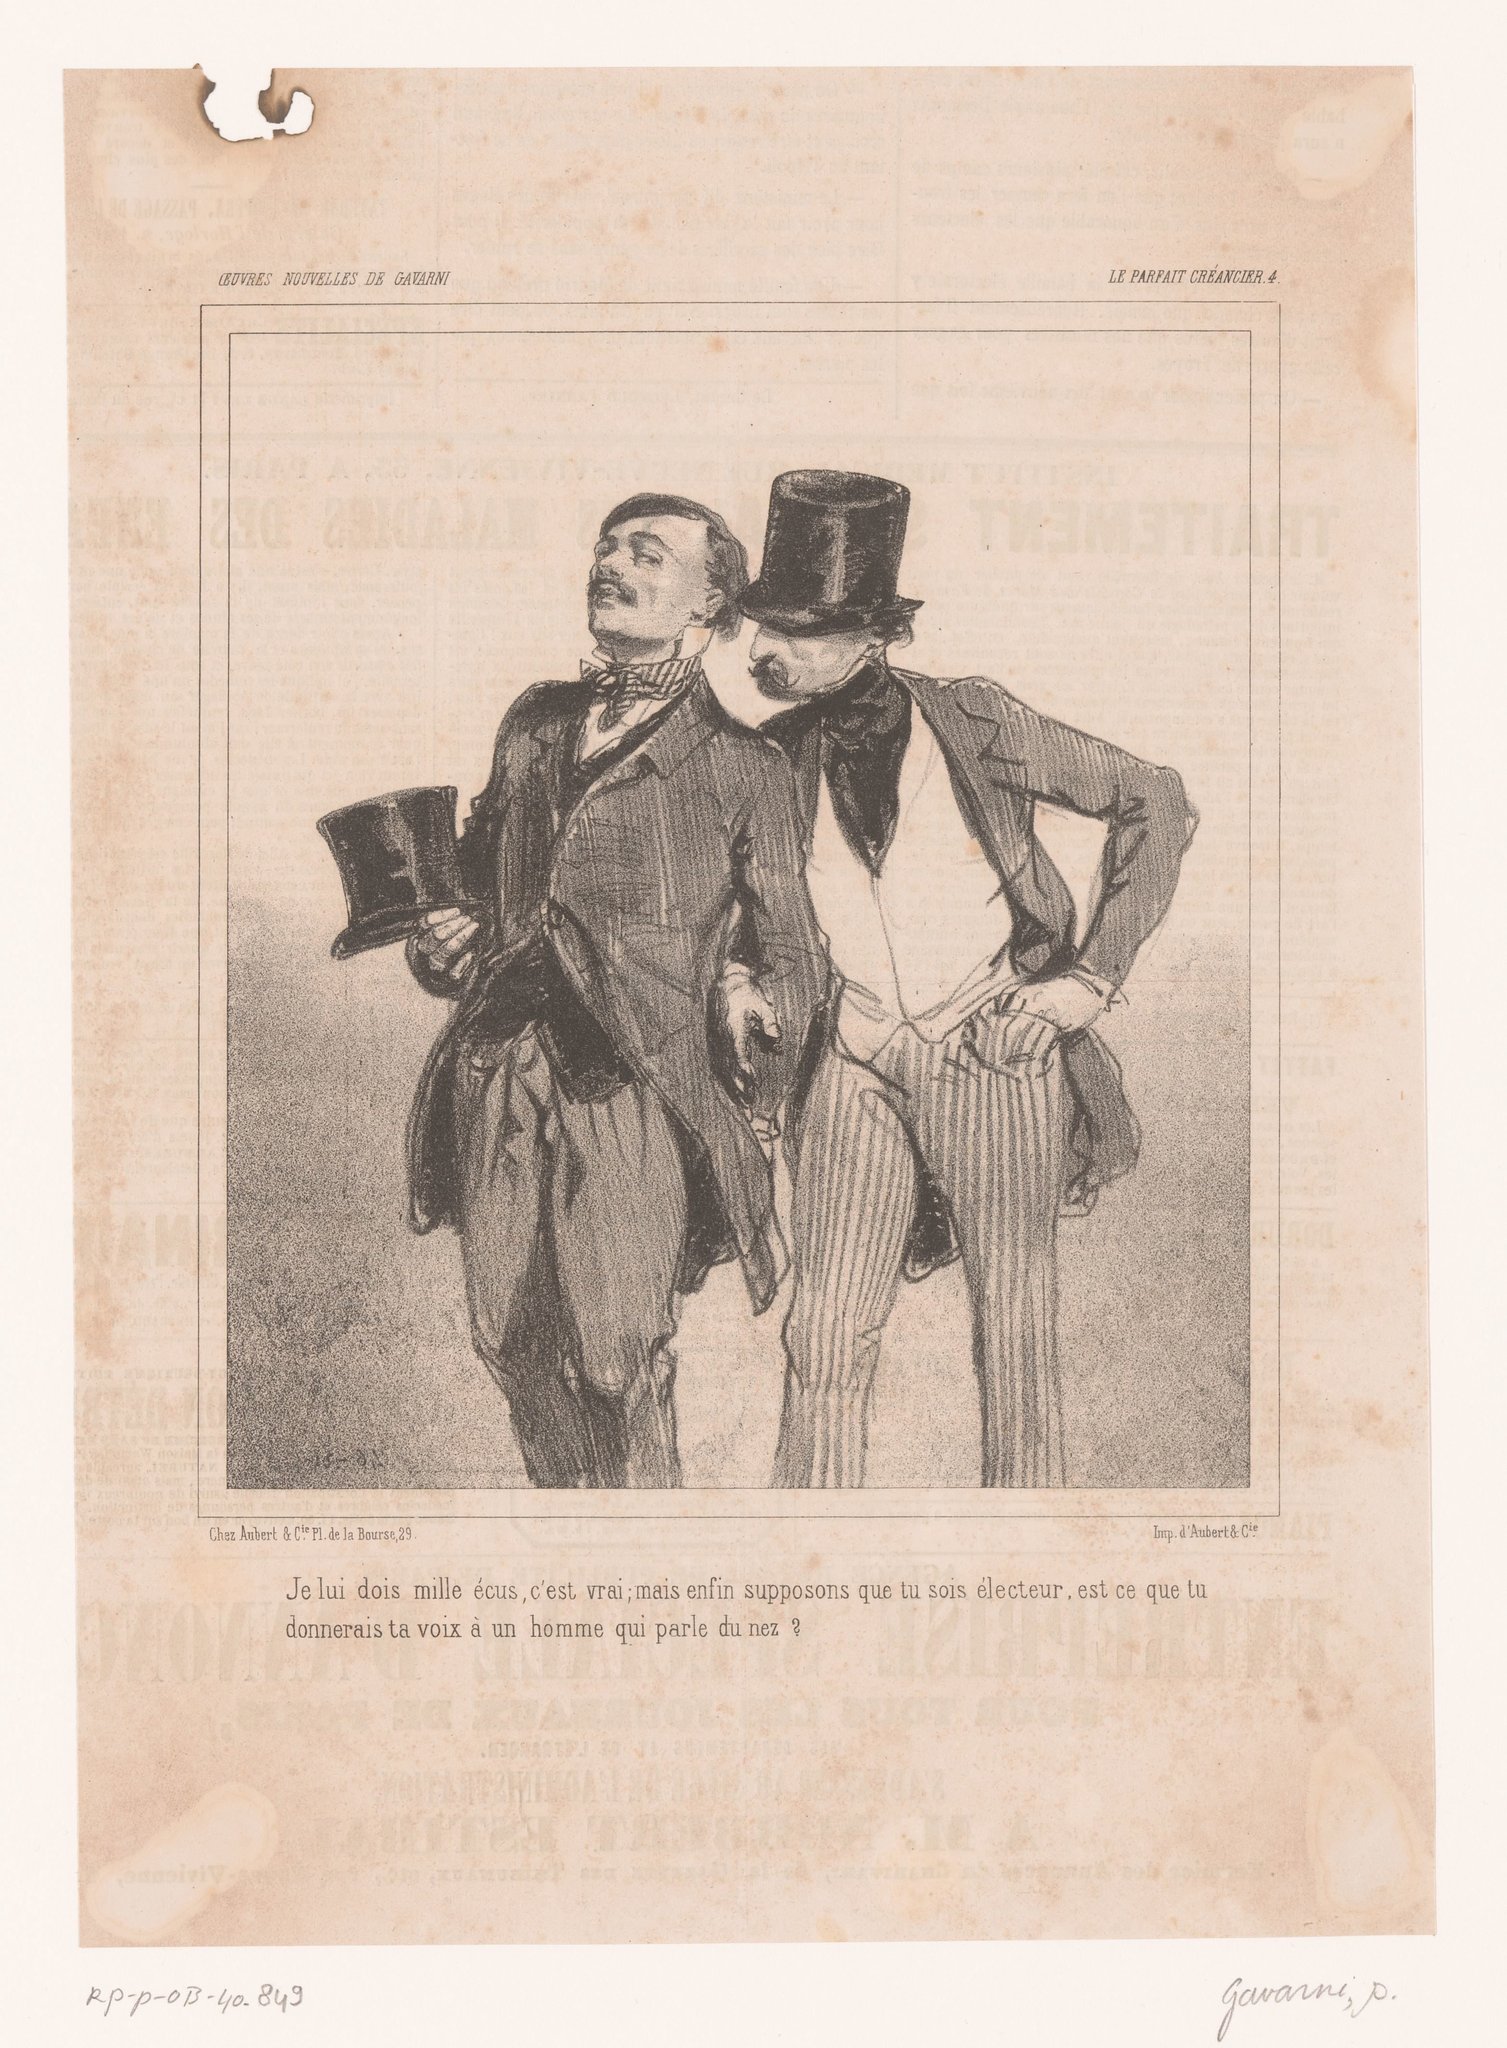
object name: print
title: Schuldeisers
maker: paul gavarni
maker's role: draughtsman, print maker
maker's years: 1804-1866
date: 1846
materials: paper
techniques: lithograph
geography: paris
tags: credit, walking, conversation, dialogue; conversation piece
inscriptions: collector's mark: Lugt 2228a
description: Prent gebruikt voor: Le Charivari, 7 juli 1846.